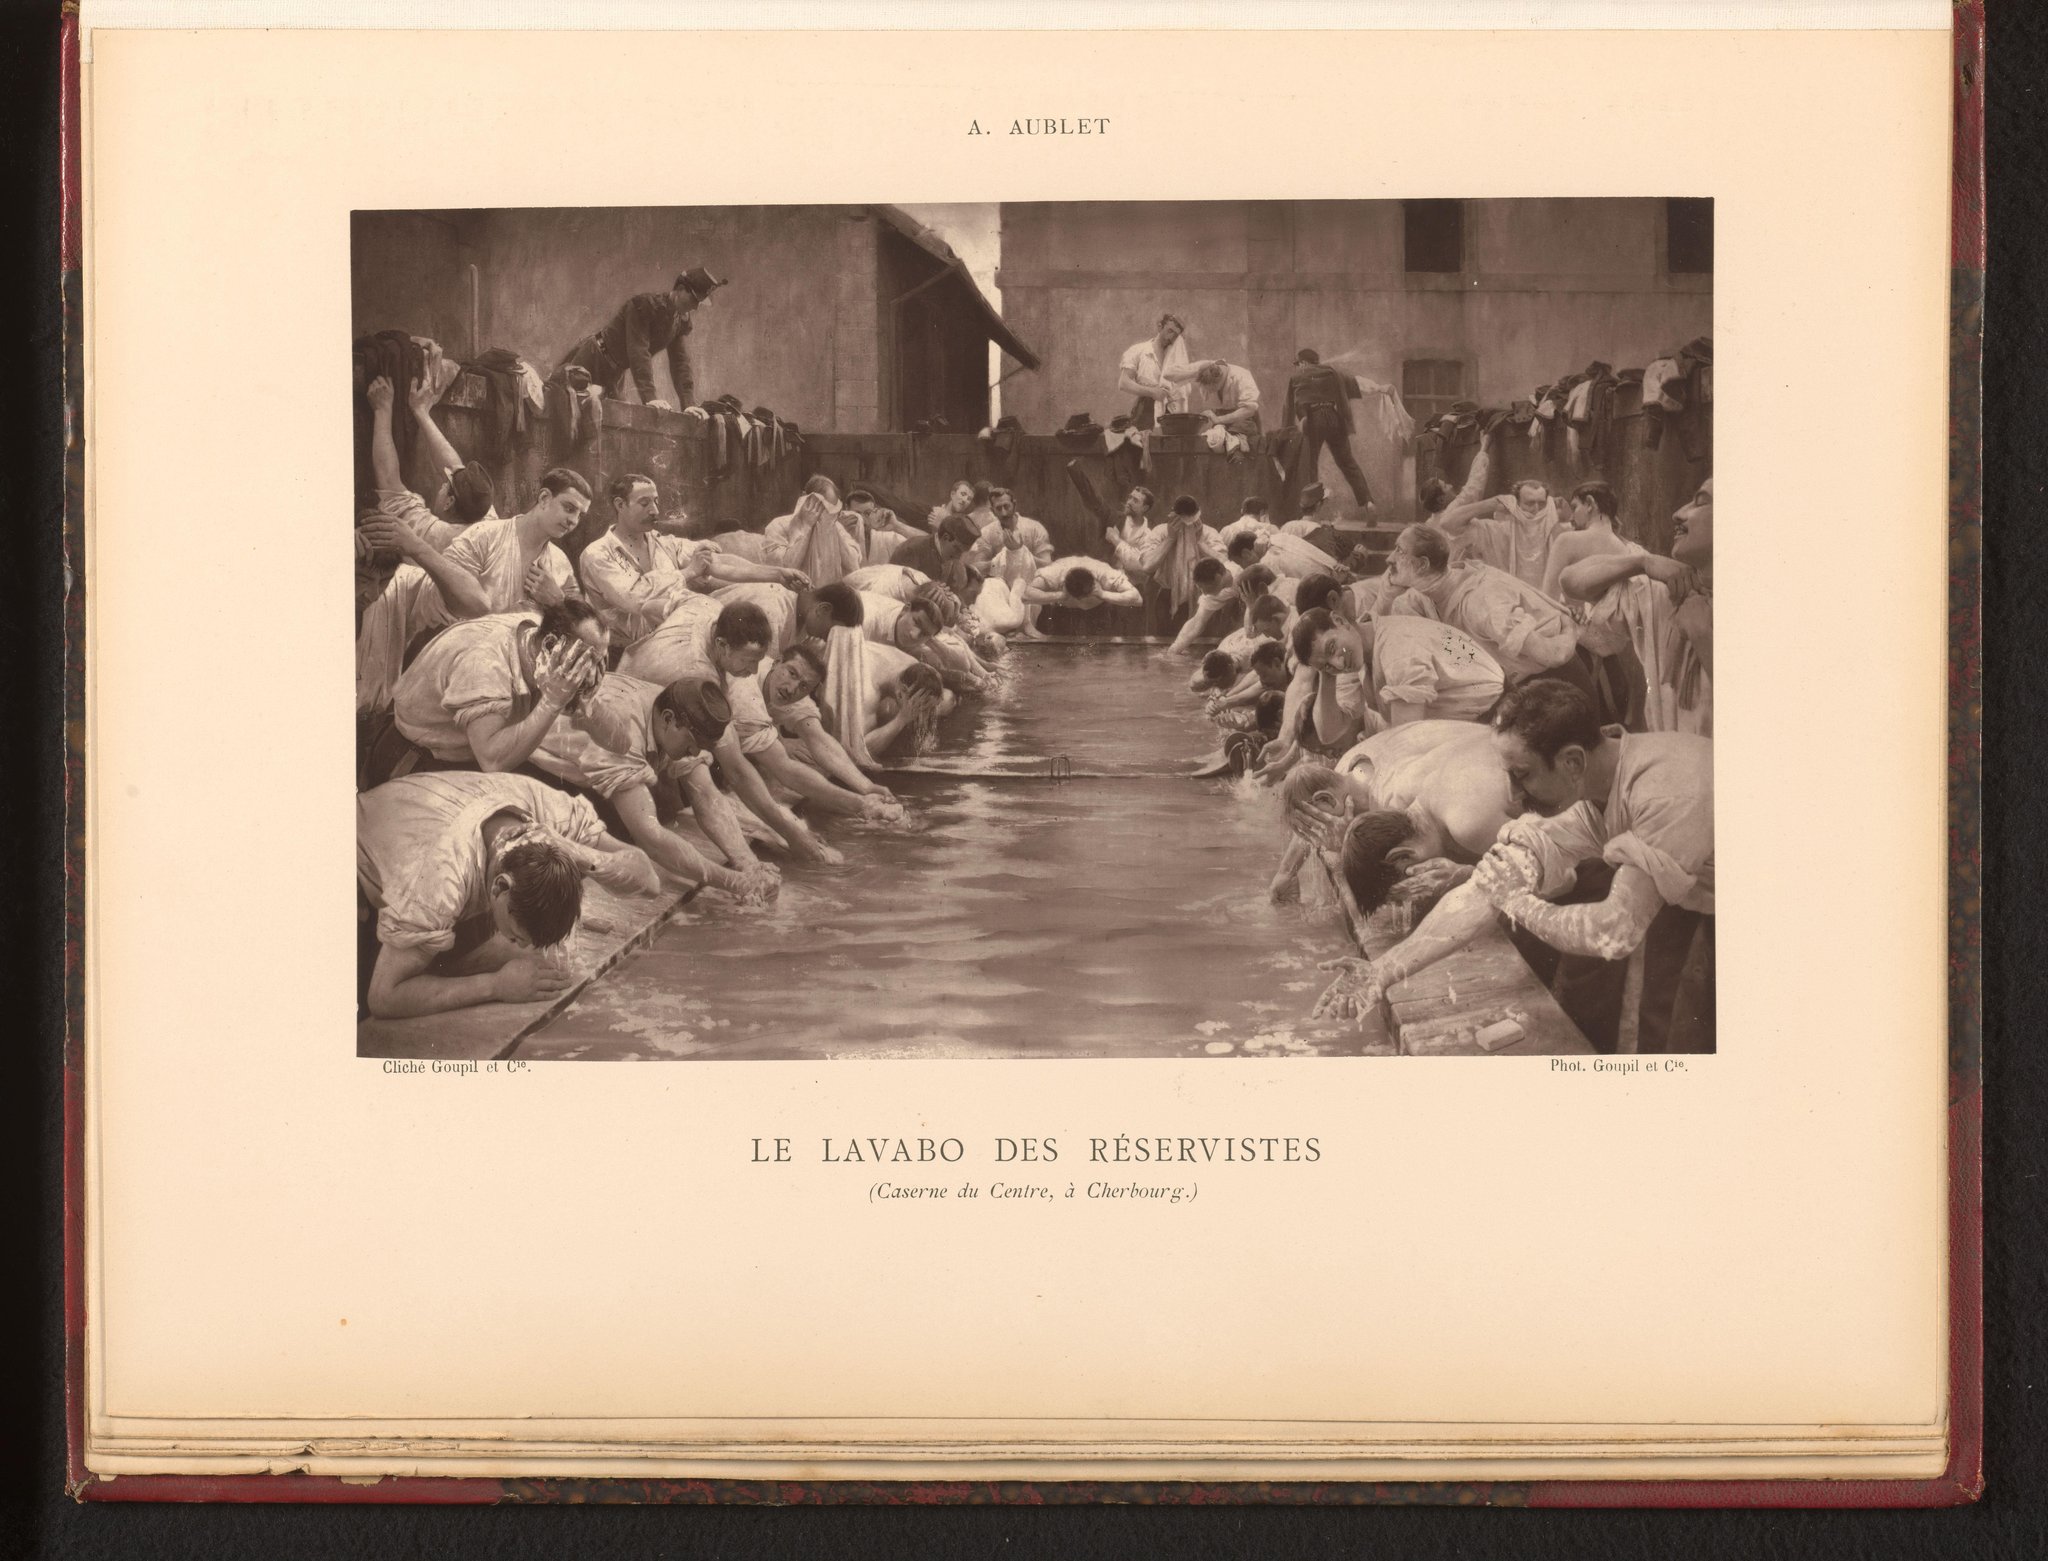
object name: photomechanical print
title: Le lavabo des réservistes (Caserne du Centre, à Cherbourg)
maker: albert louis aublet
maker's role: painter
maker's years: 1851-1938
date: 1877-1882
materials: paper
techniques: woodburytype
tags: the soldier; the soldier's life